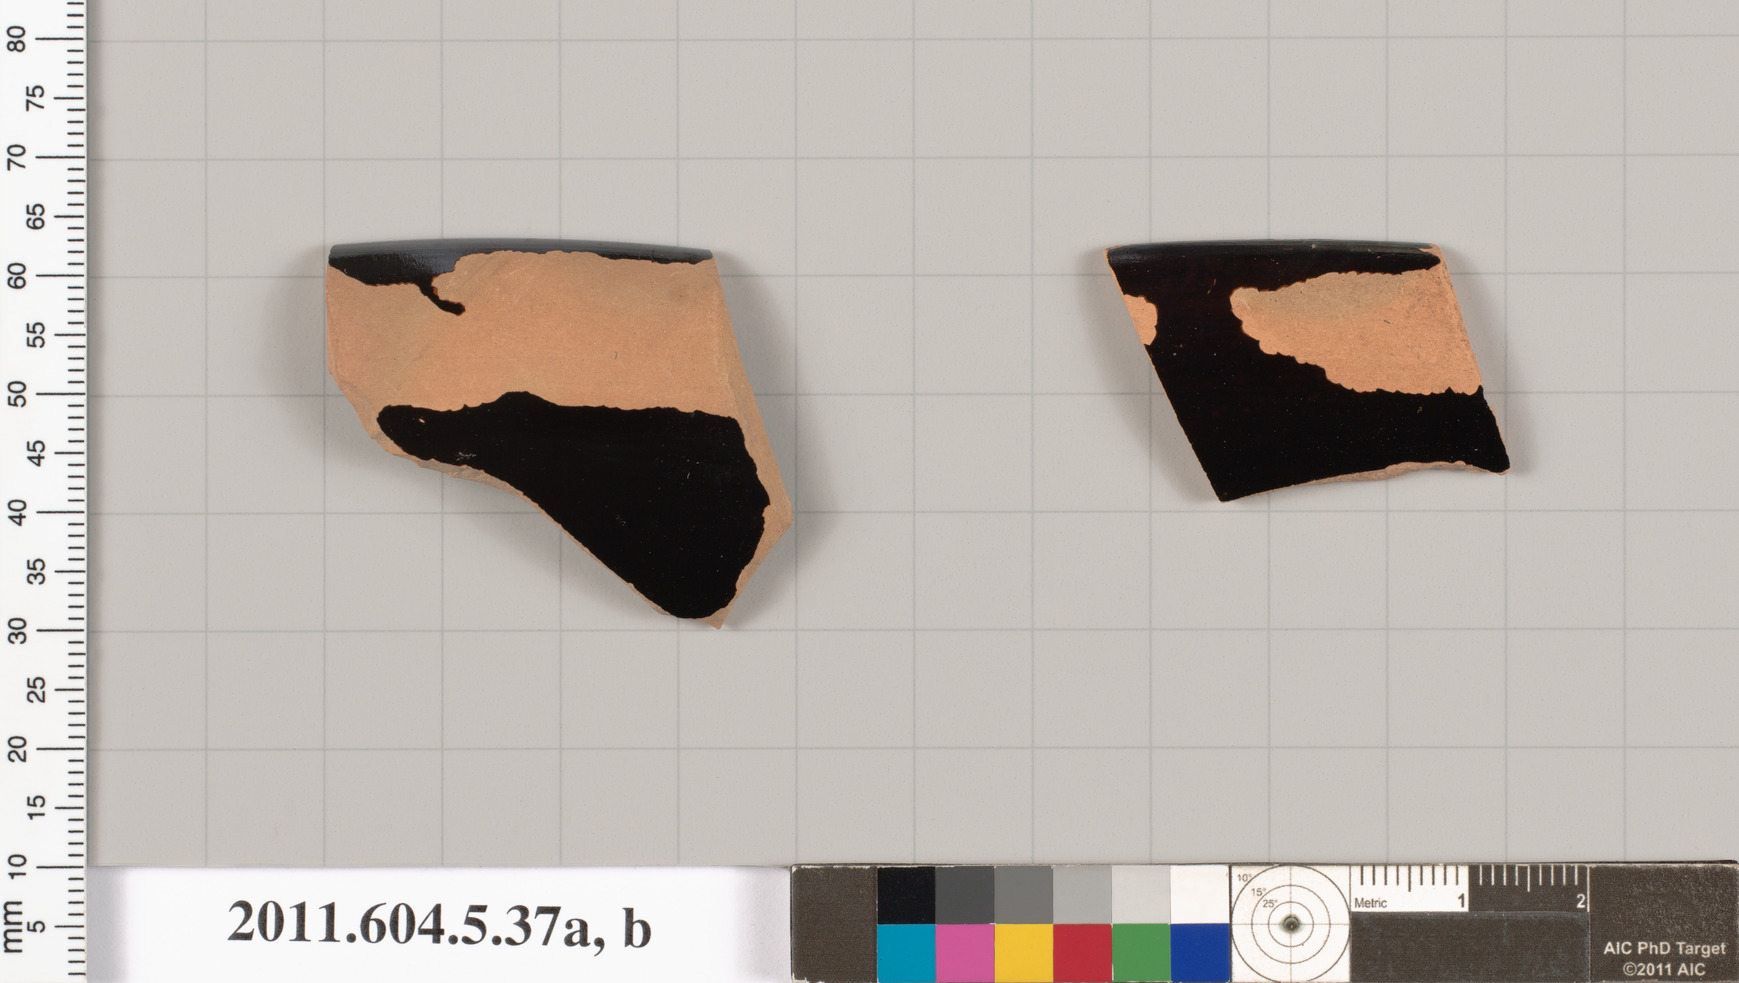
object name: kylix fragment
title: Terracotta rim fragments of a kylix (drinking cup)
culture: greek, attic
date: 475-451 BCE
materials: terracotta